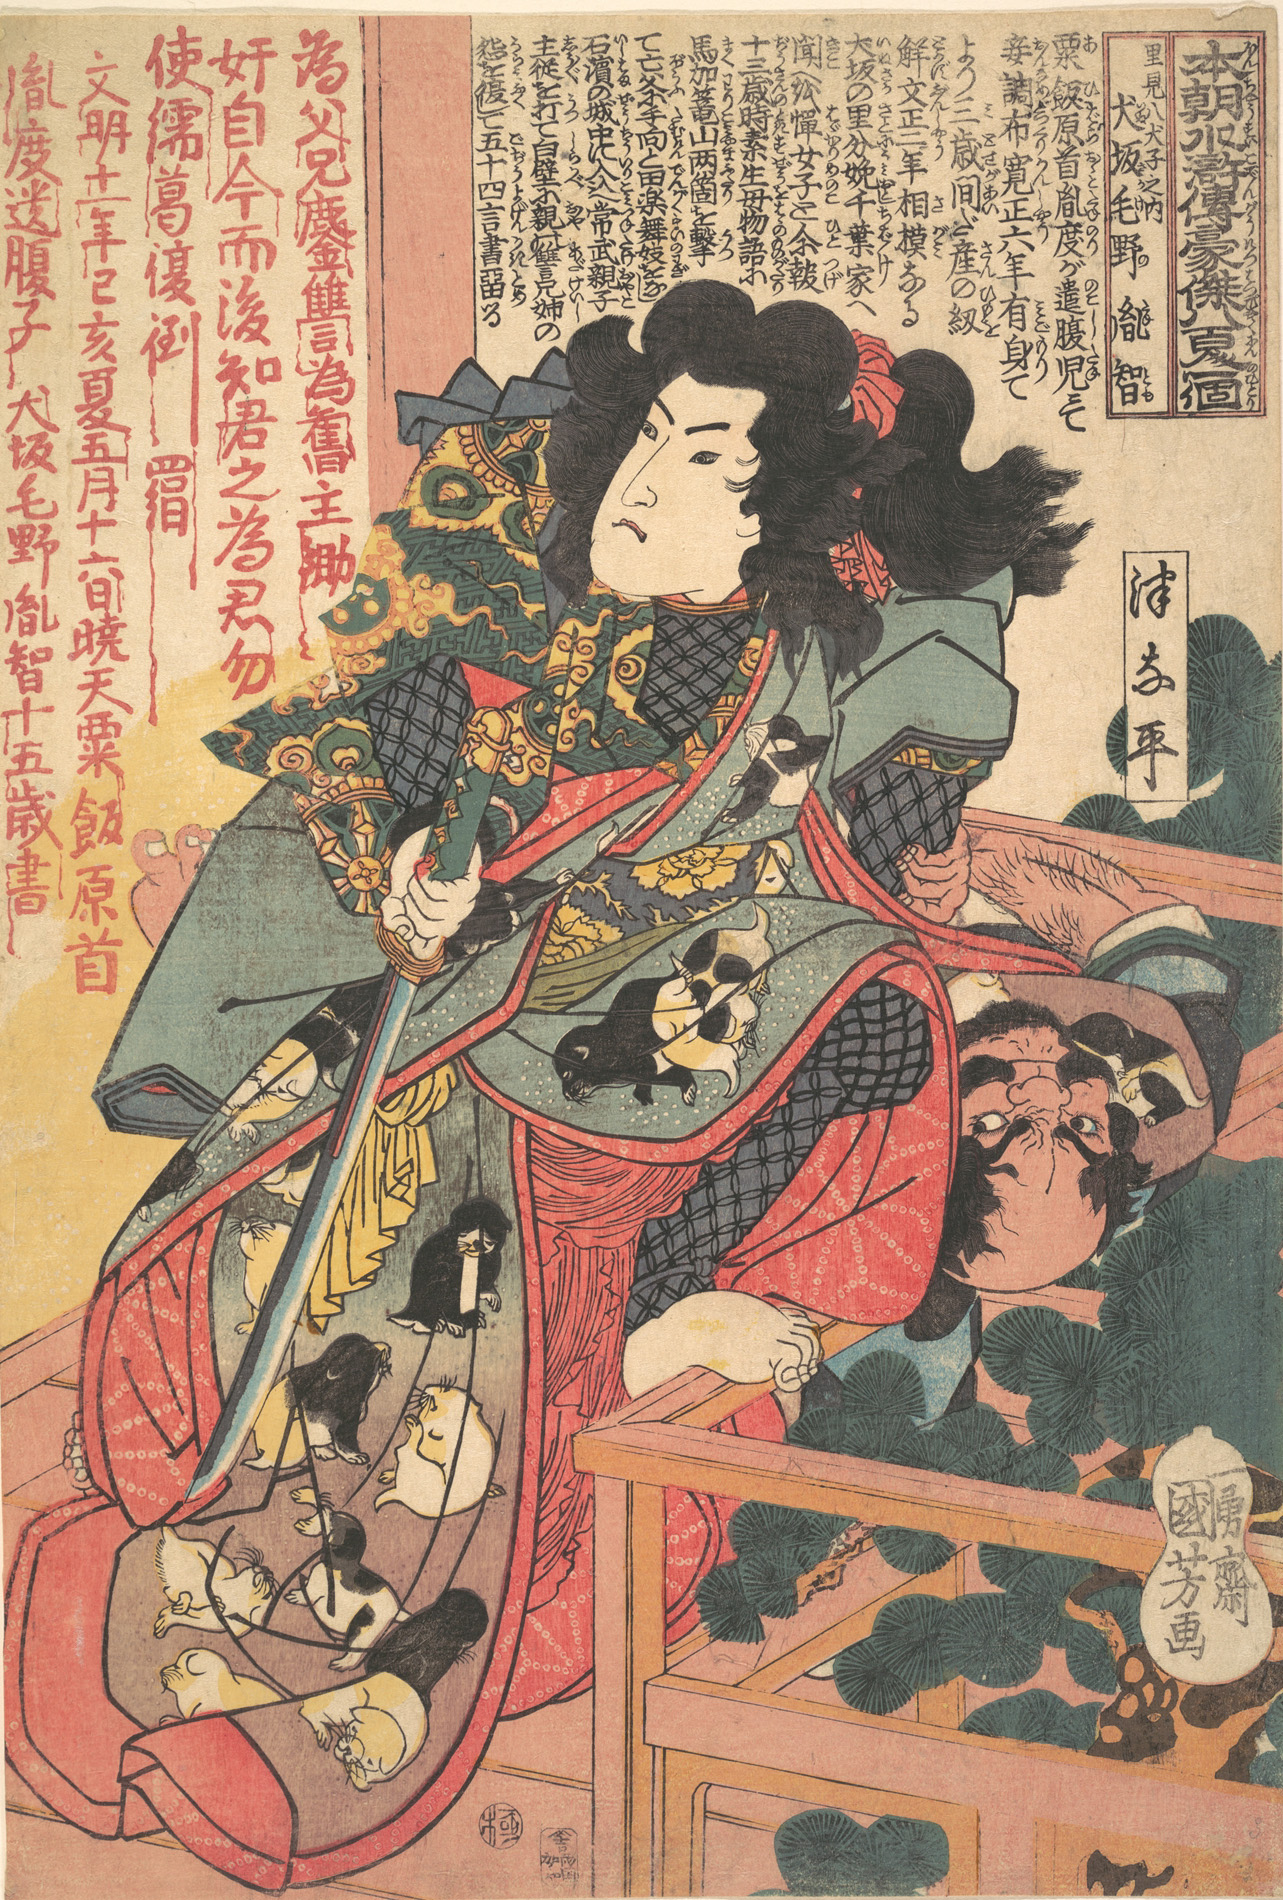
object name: print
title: Inuzaka Keno Tanetomo from Story of Eight Dogs (Hakkenden)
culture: japanese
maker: utagawa kuniyoshi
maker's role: artist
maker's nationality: japanese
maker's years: 1797-1861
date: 1830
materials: ink, paper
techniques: woodblock print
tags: swords,men